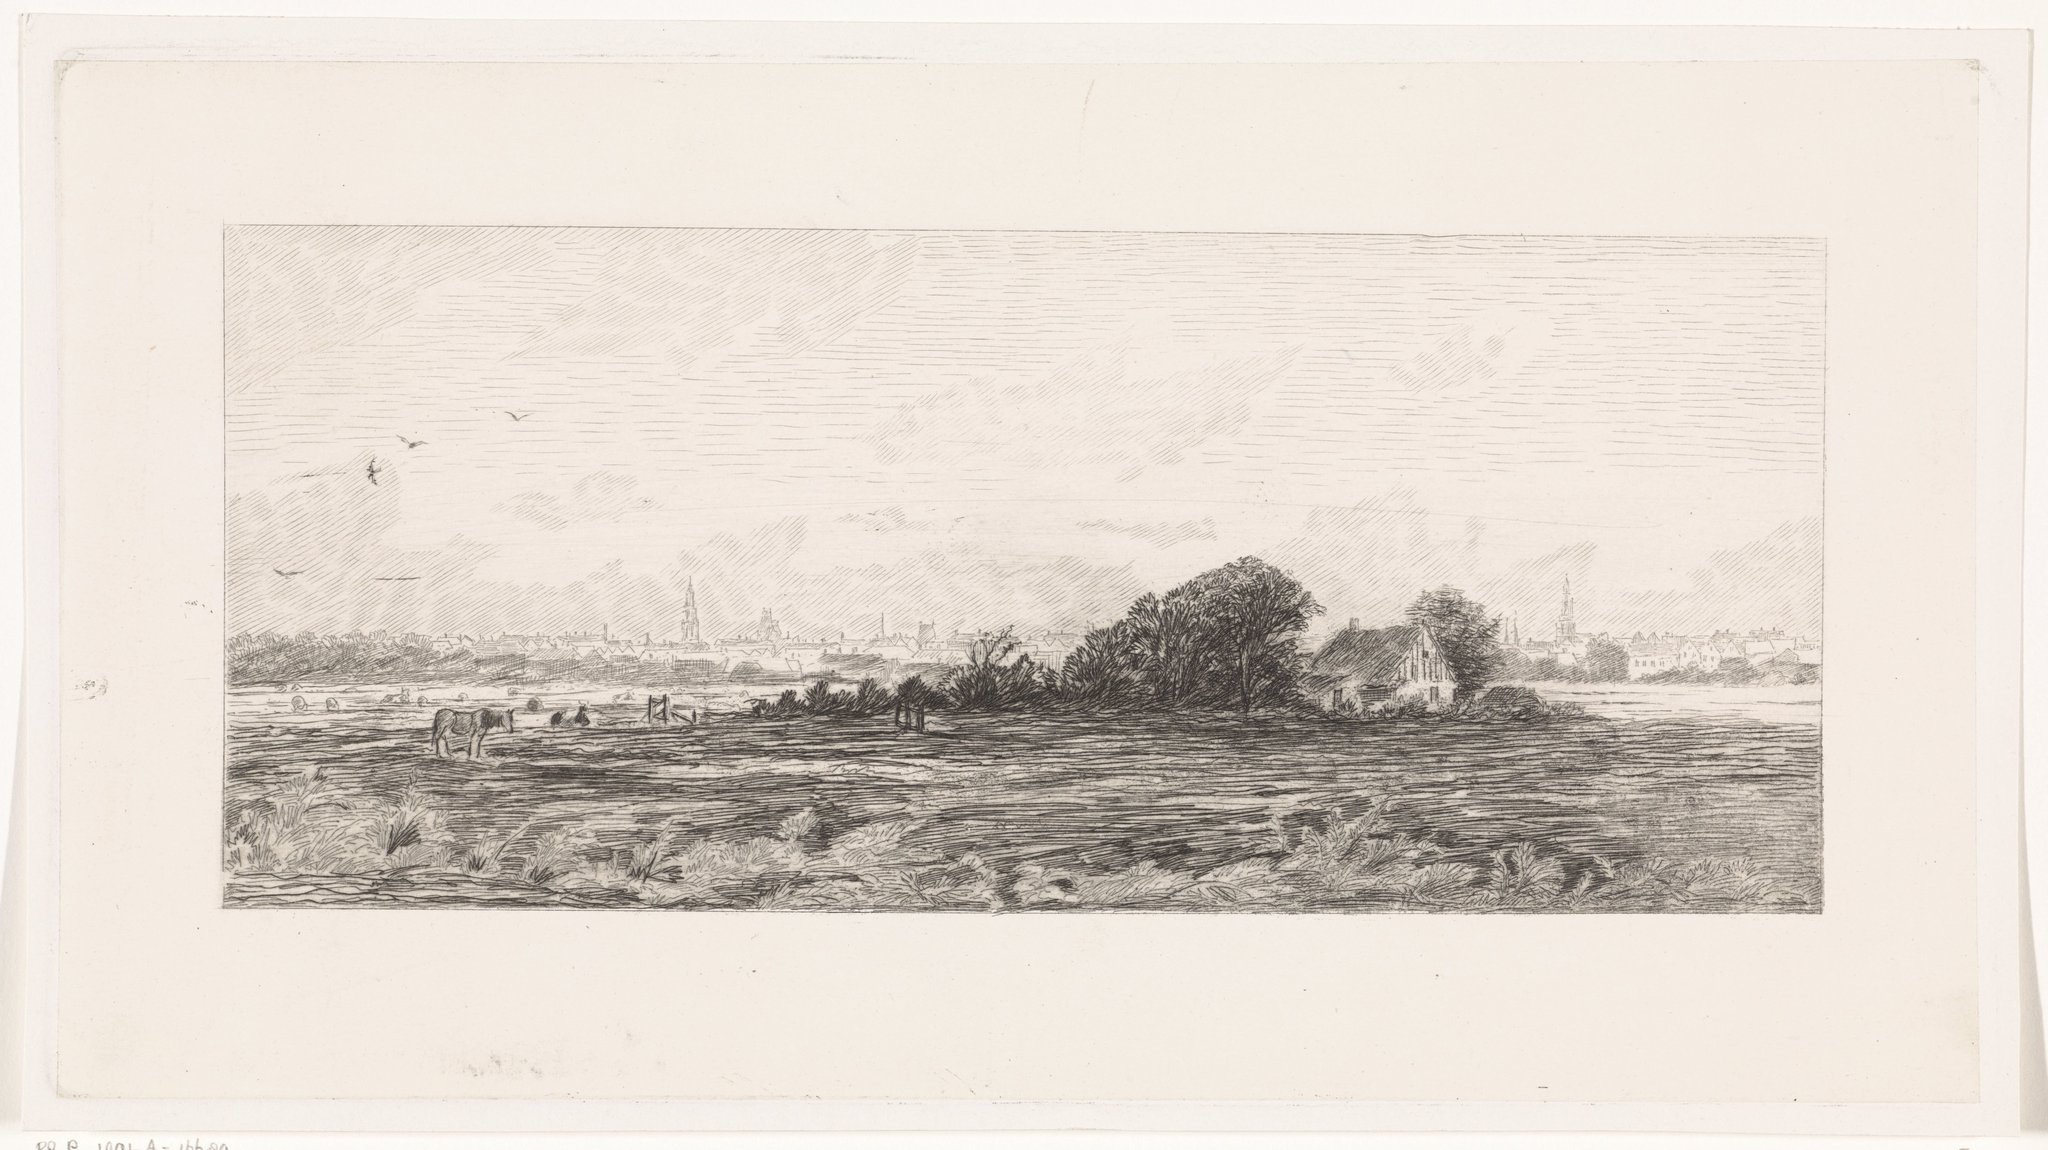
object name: print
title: Stadsgezicht met weilanden op de voorgrond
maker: elias stark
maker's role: draughtsman, print maker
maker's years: 1849-1933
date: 1859-1891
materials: paper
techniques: etching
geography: nieuwer-amstel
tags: city-view in general; 'veduta', meadow, pasture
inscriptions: collector's mark: Lugt 2228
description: Zicht op weilanden en een boerderij en aan de horizon een stad.